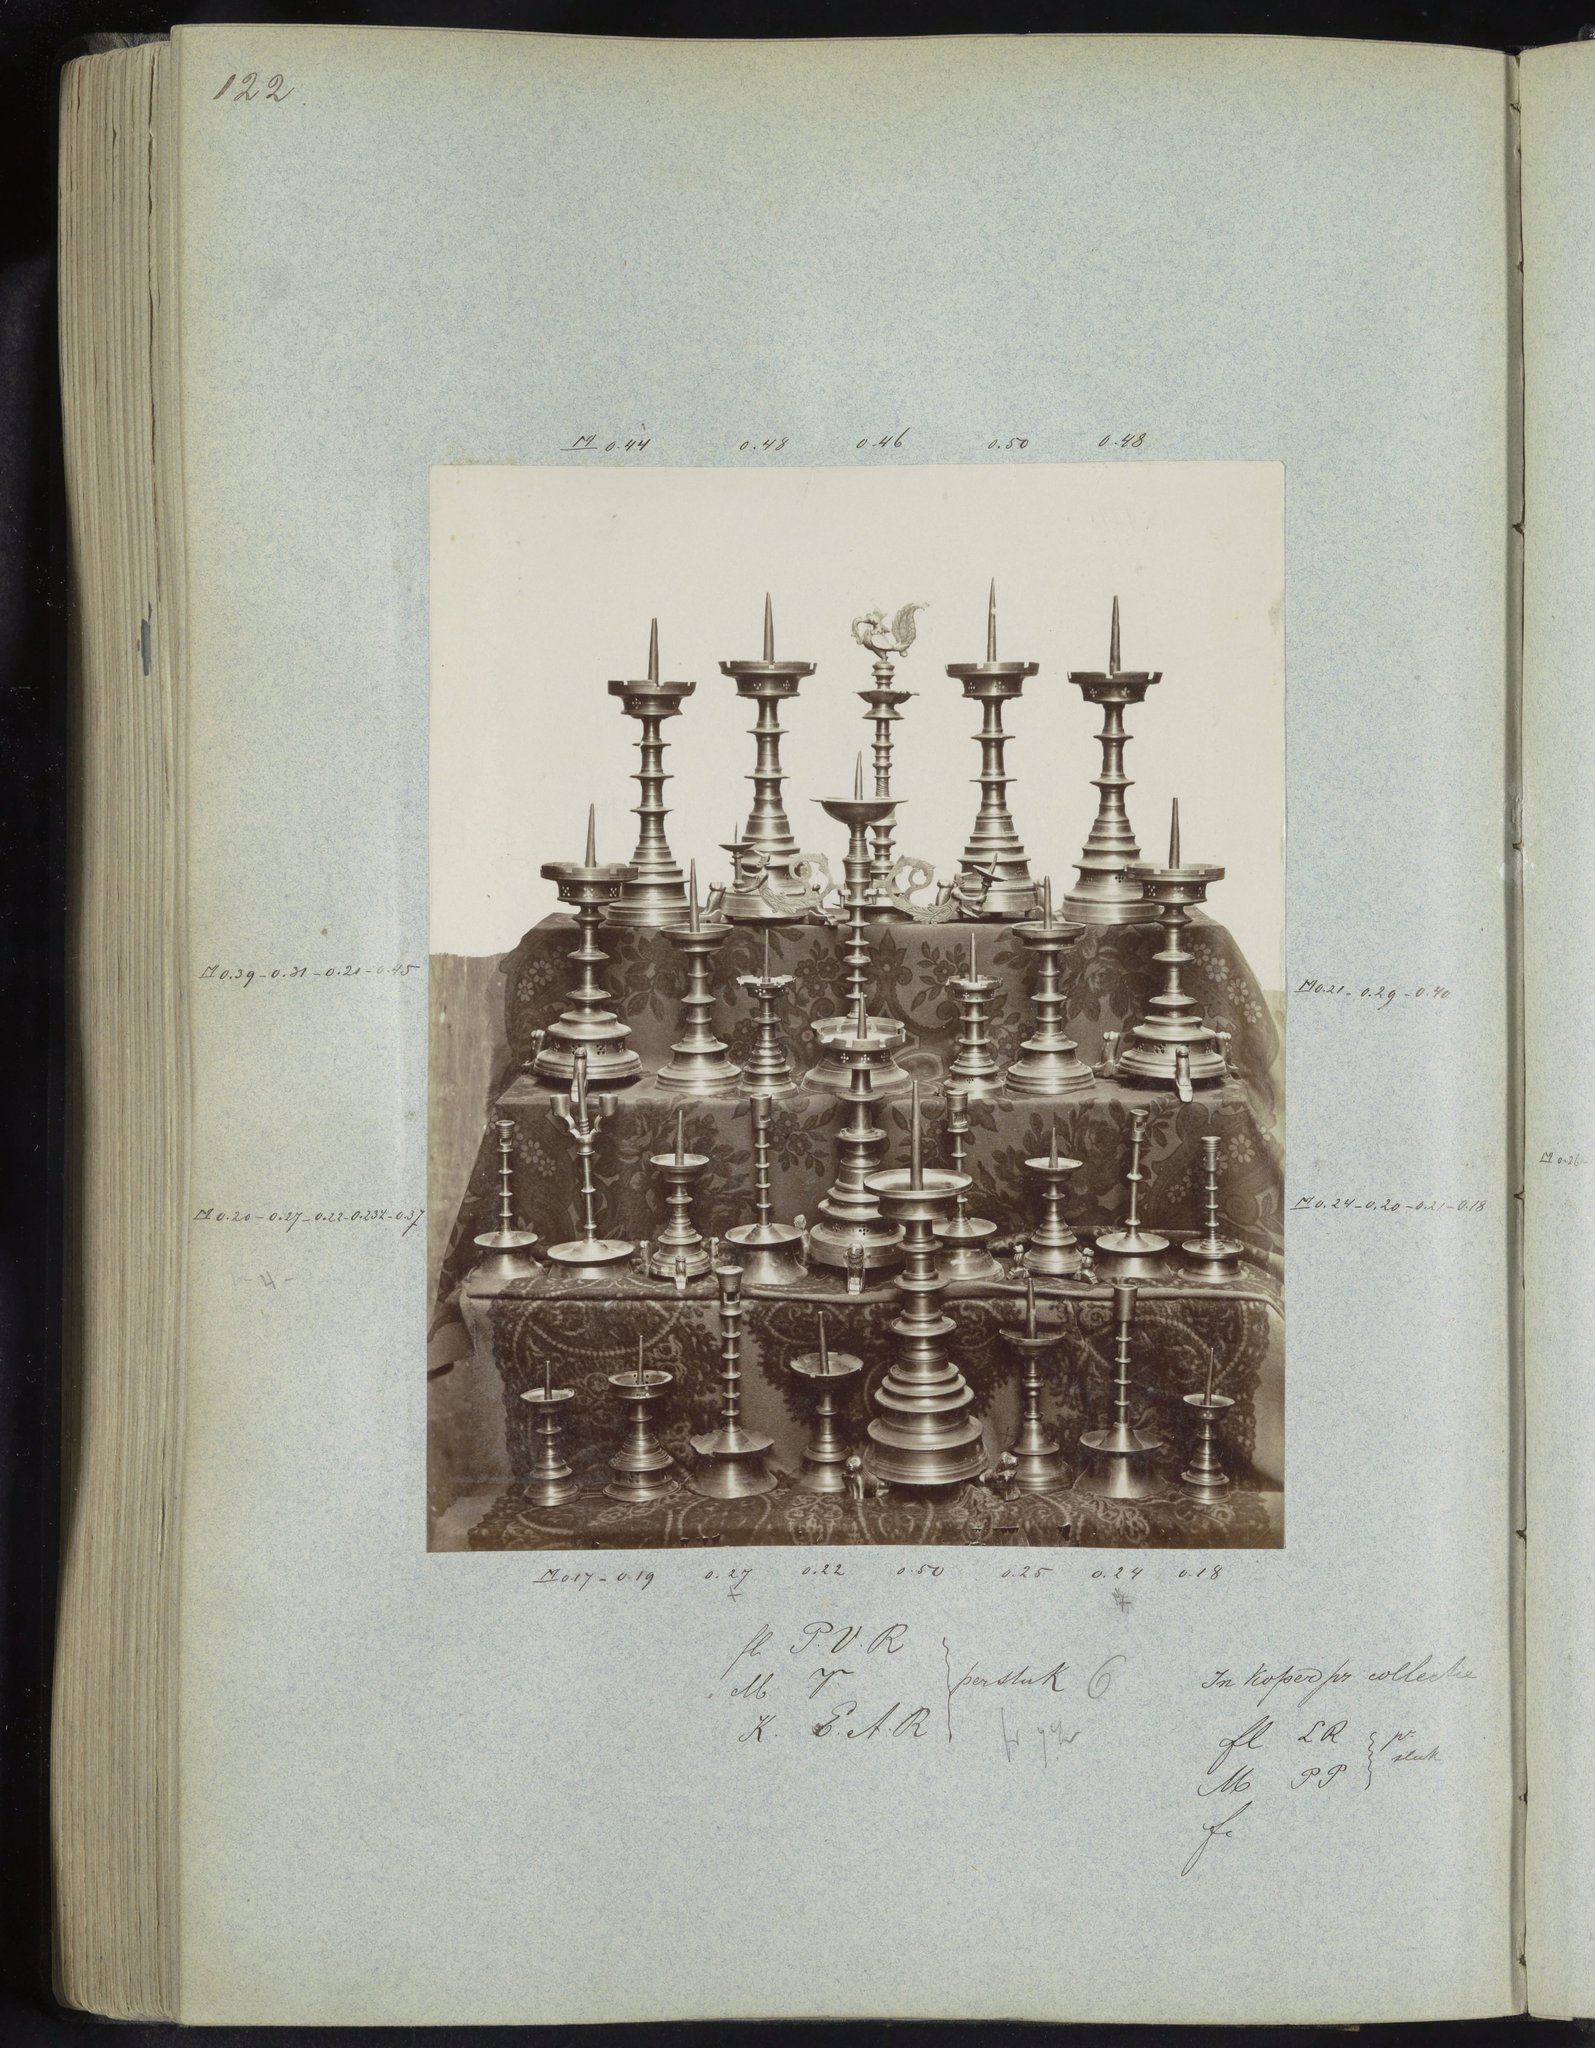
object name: album leaf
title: Negenentwintig koperen kandelaars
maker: Anonymous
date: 1875-1900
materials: paper, photographic support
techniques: albumen print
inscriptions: annotation, annotation